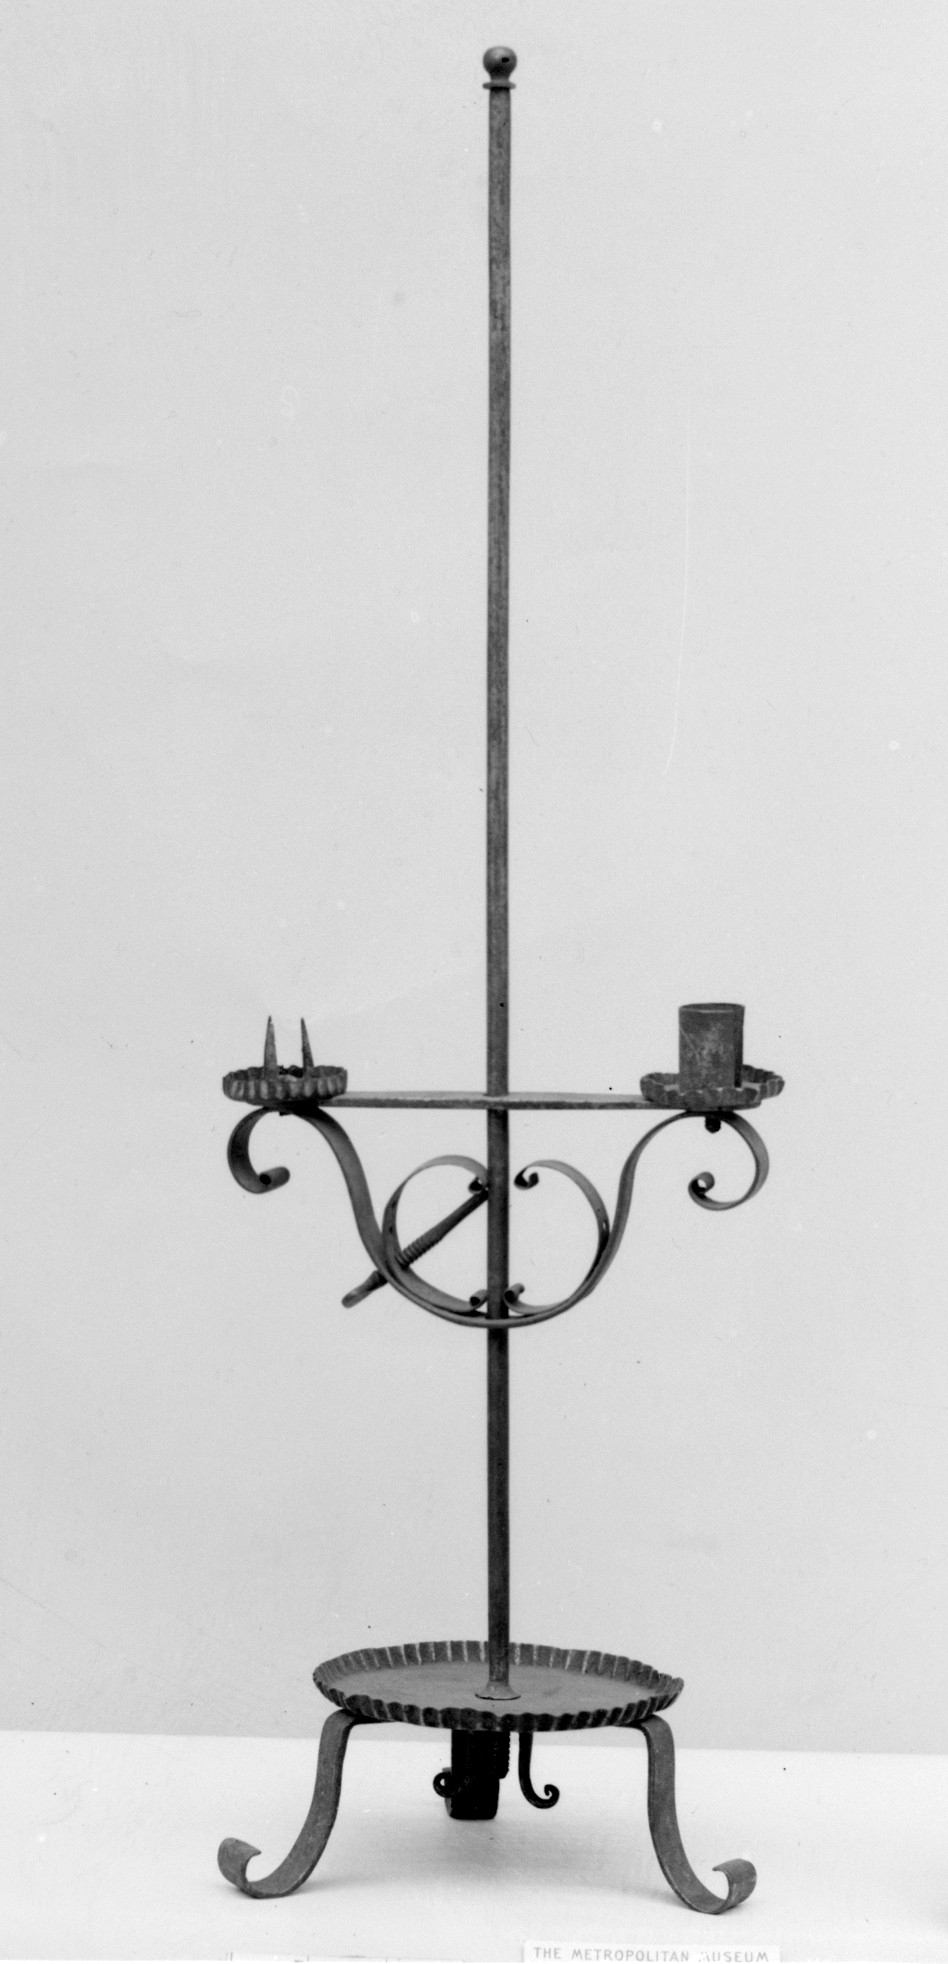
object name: candlestick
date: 1567-1600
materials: iron